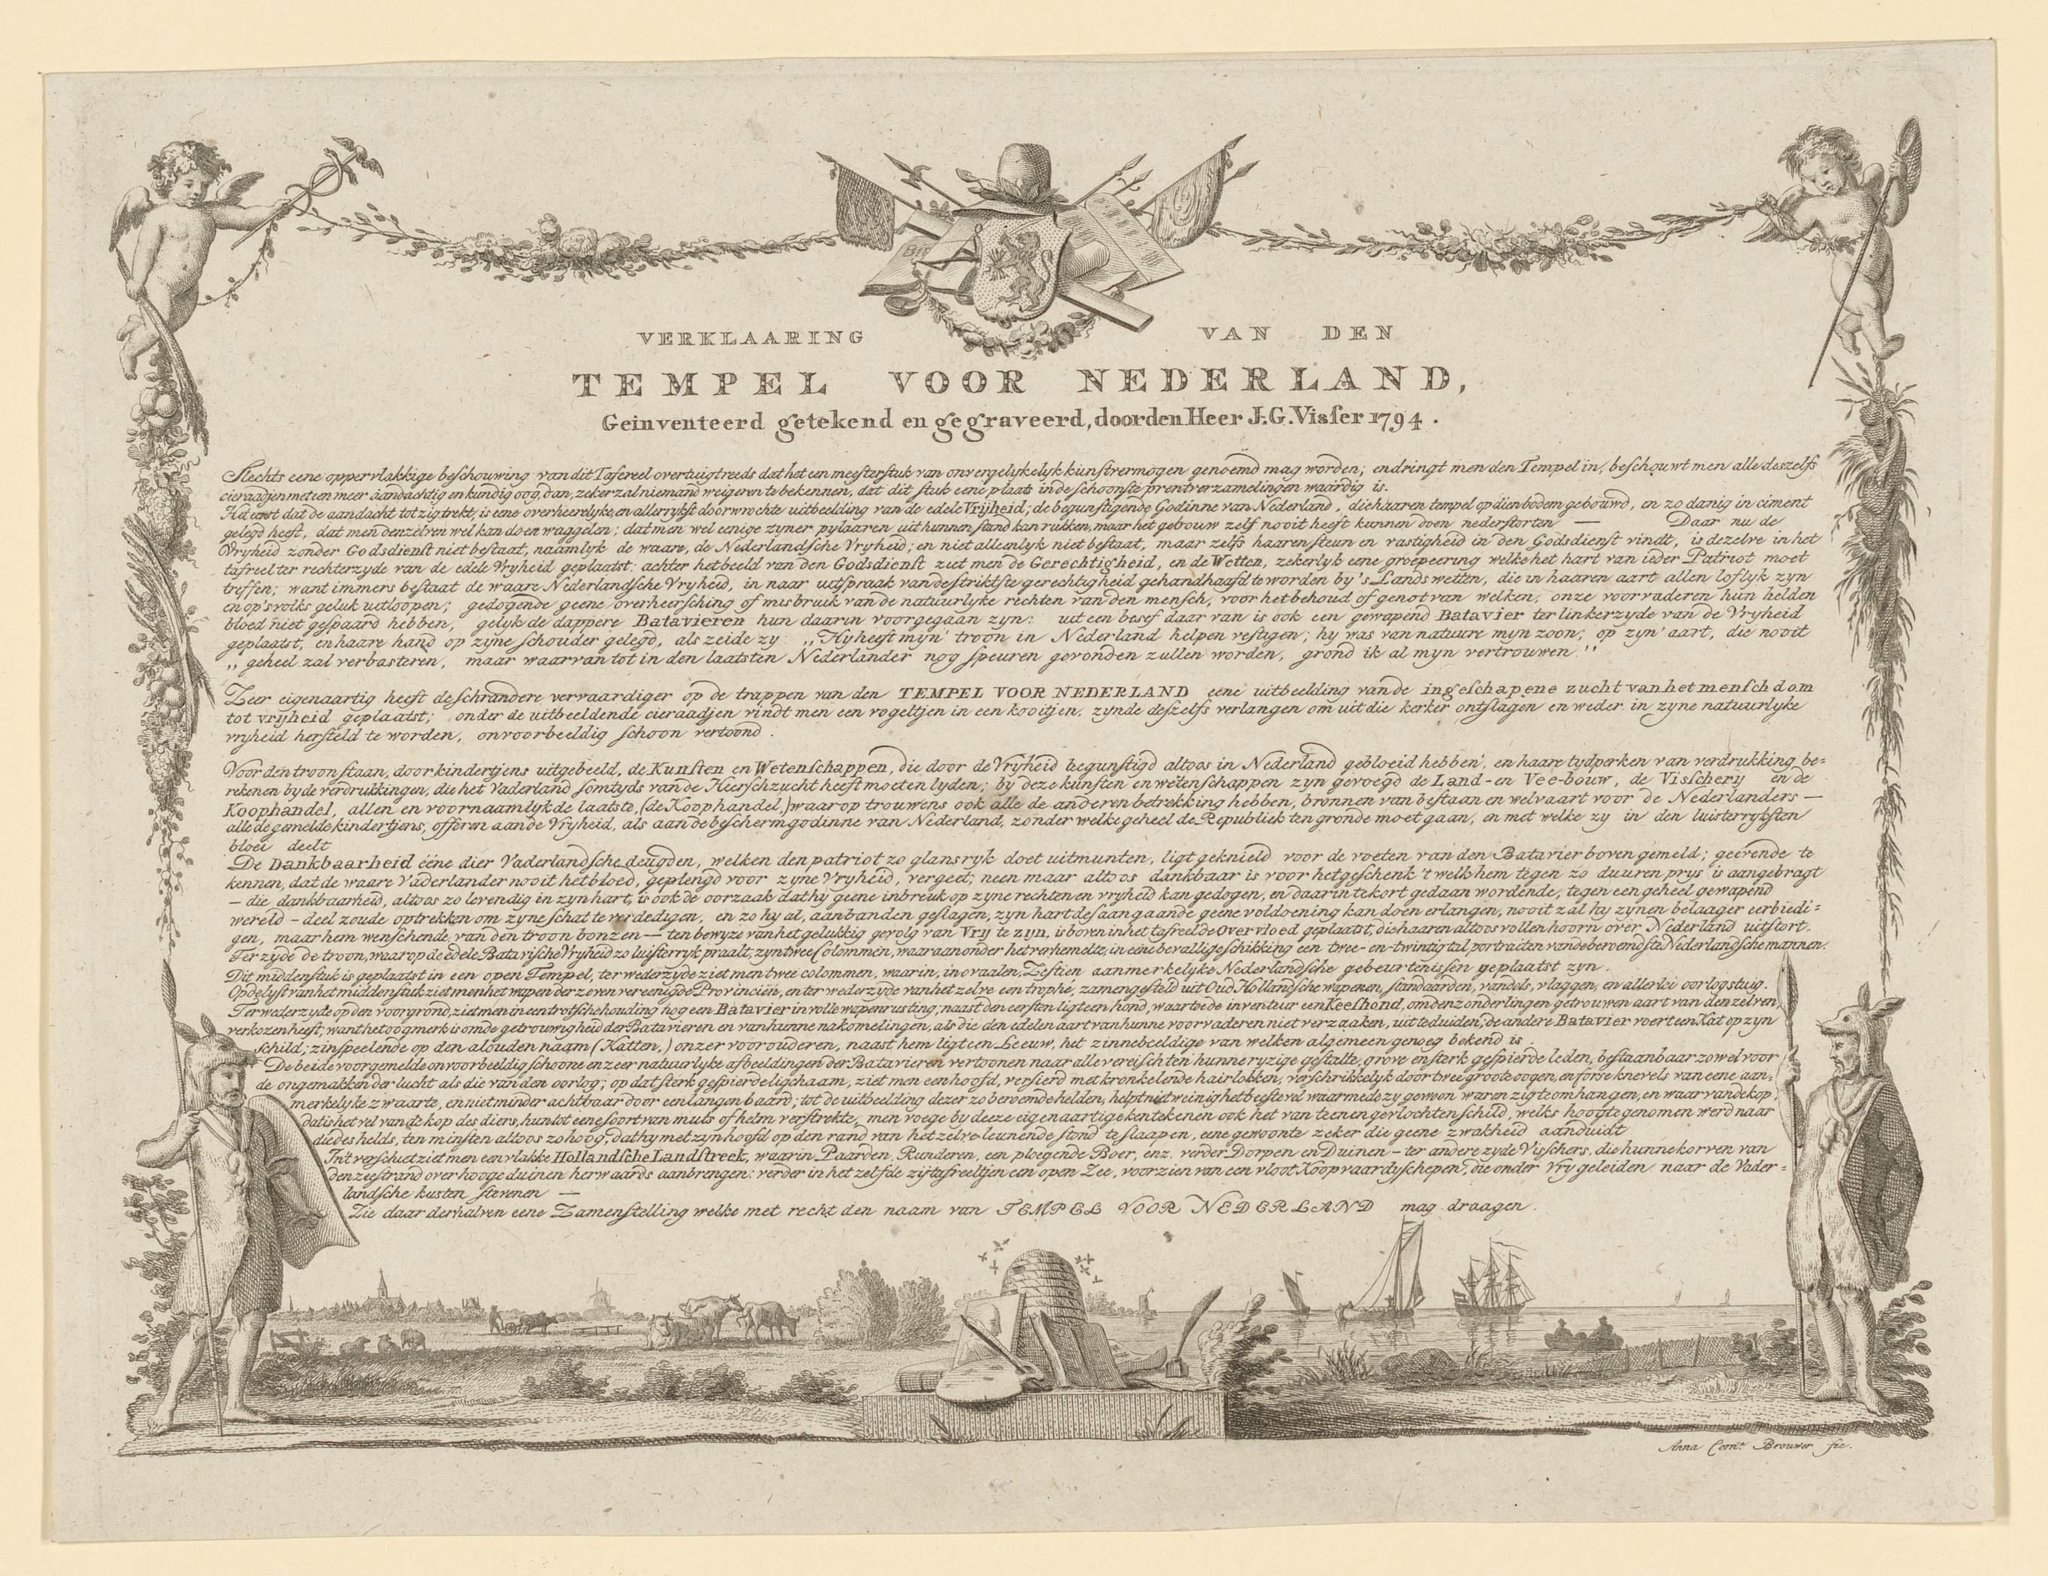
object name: print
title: Verklaaring van den Tempel voor Nederland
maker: anna catharina brouwer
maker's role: print maker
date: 1794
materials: paper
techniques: engraving, etching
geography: netherlands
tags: extinct, 'historical' peoples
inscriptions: collector's mark: Lugt 2228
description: Verklaring van de voorstelling van de prent getiteld Tempel voor Nederland, 1794. Tekst binnen een kader gevormd door putti, vignetten en festoenen, onderaan het Nederlandse land met twee Batavieren.